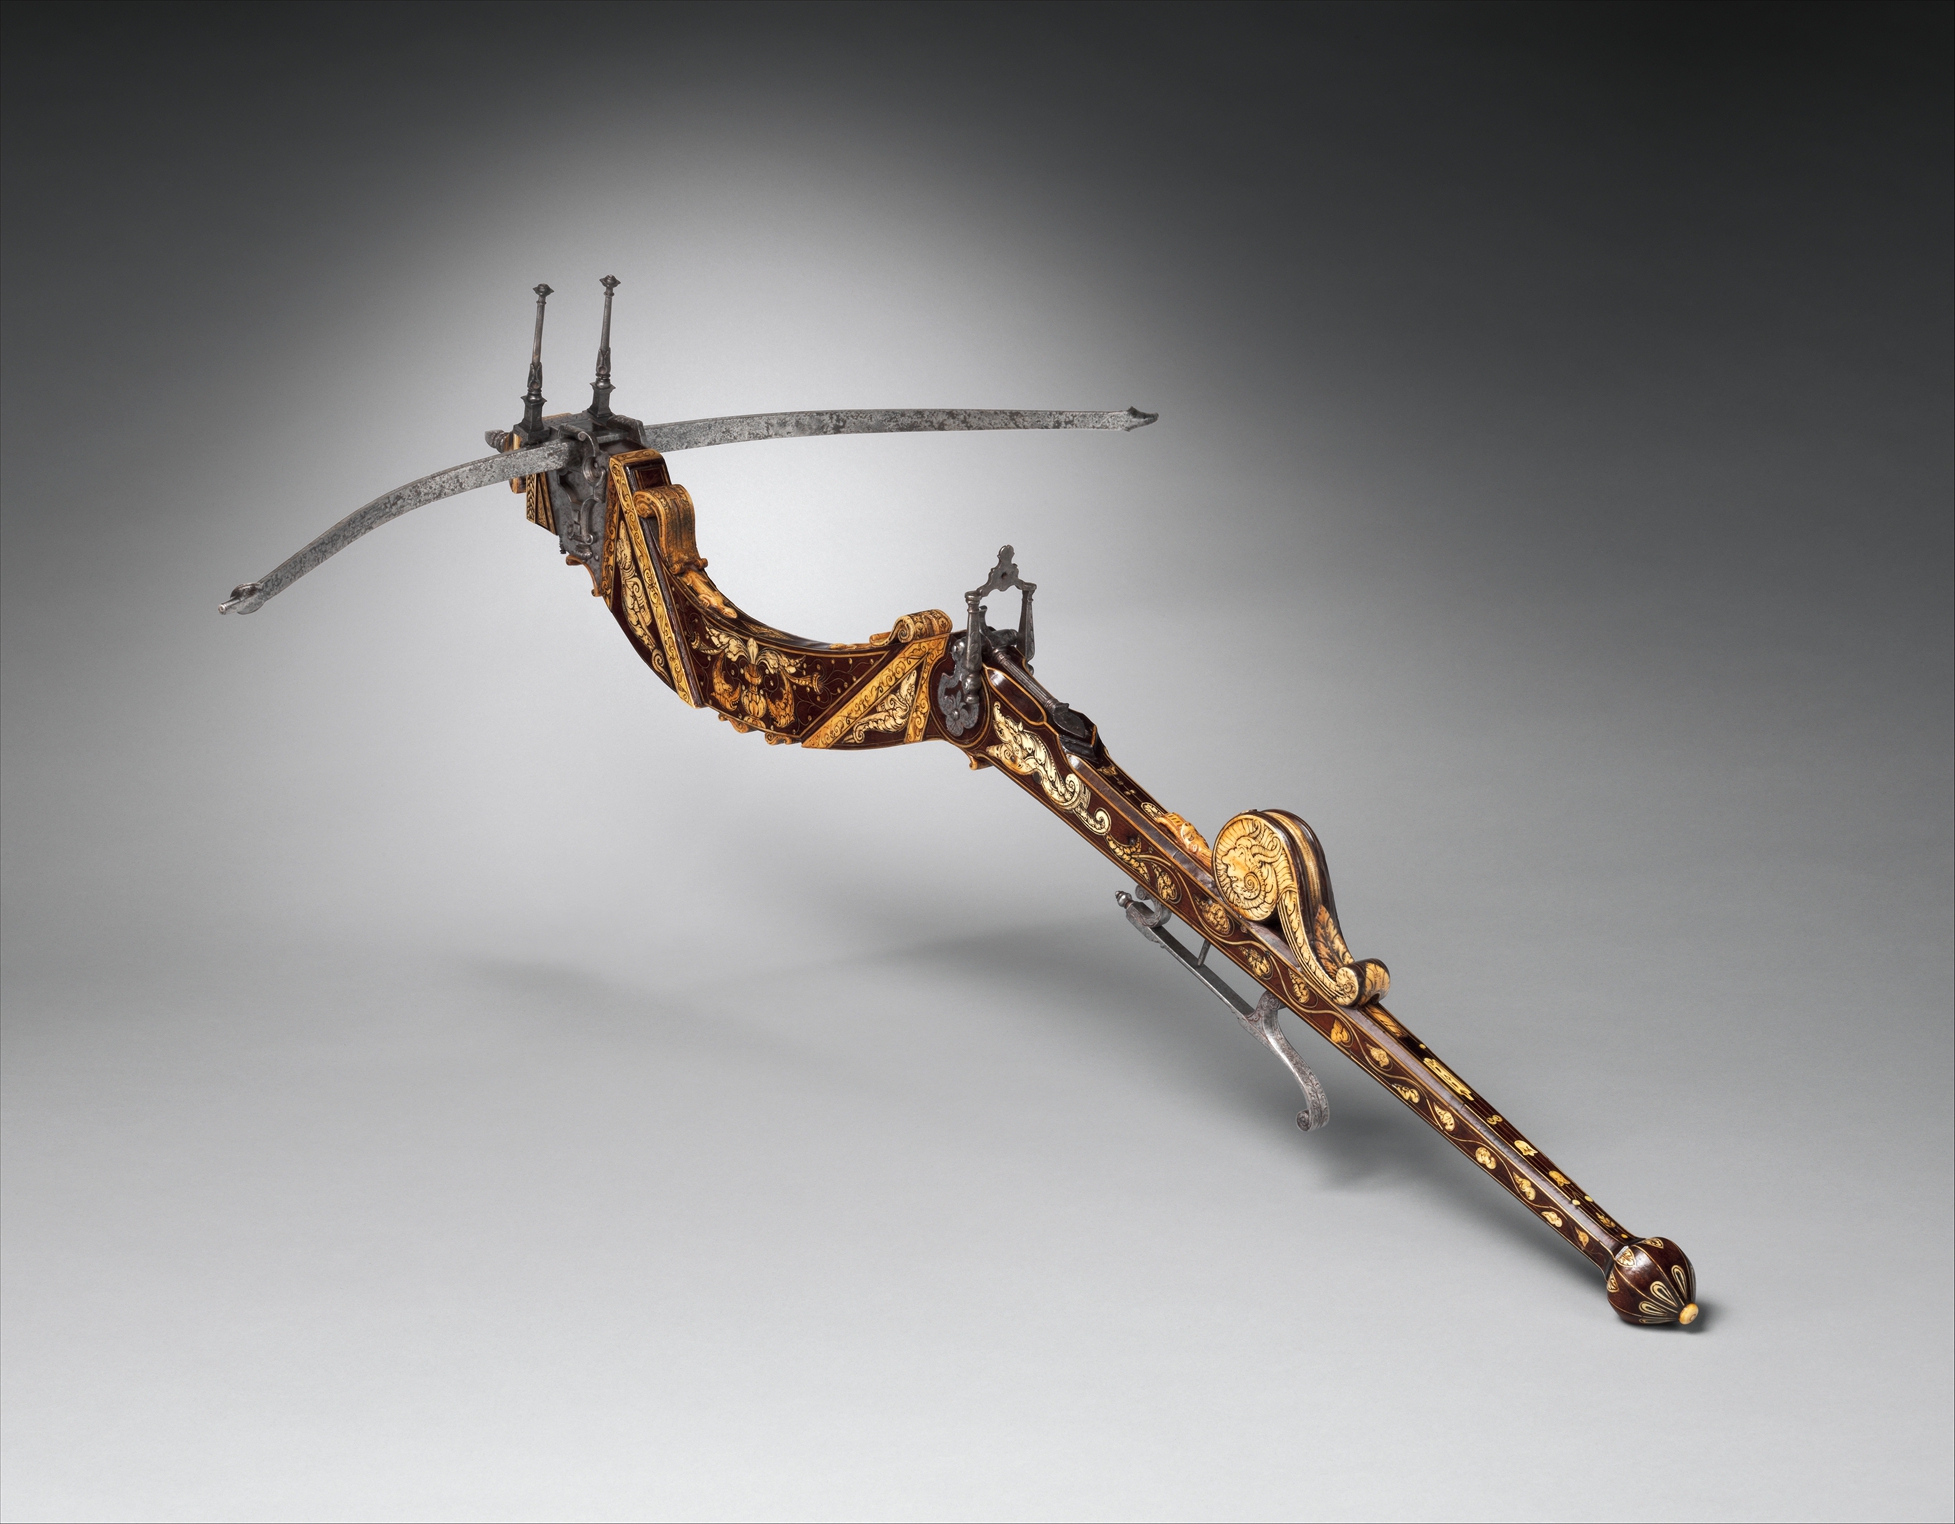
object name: pellet crossbow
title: Pellet and Bolt Crossbow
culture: northern italian or french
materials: ivory, steel, wood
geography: france